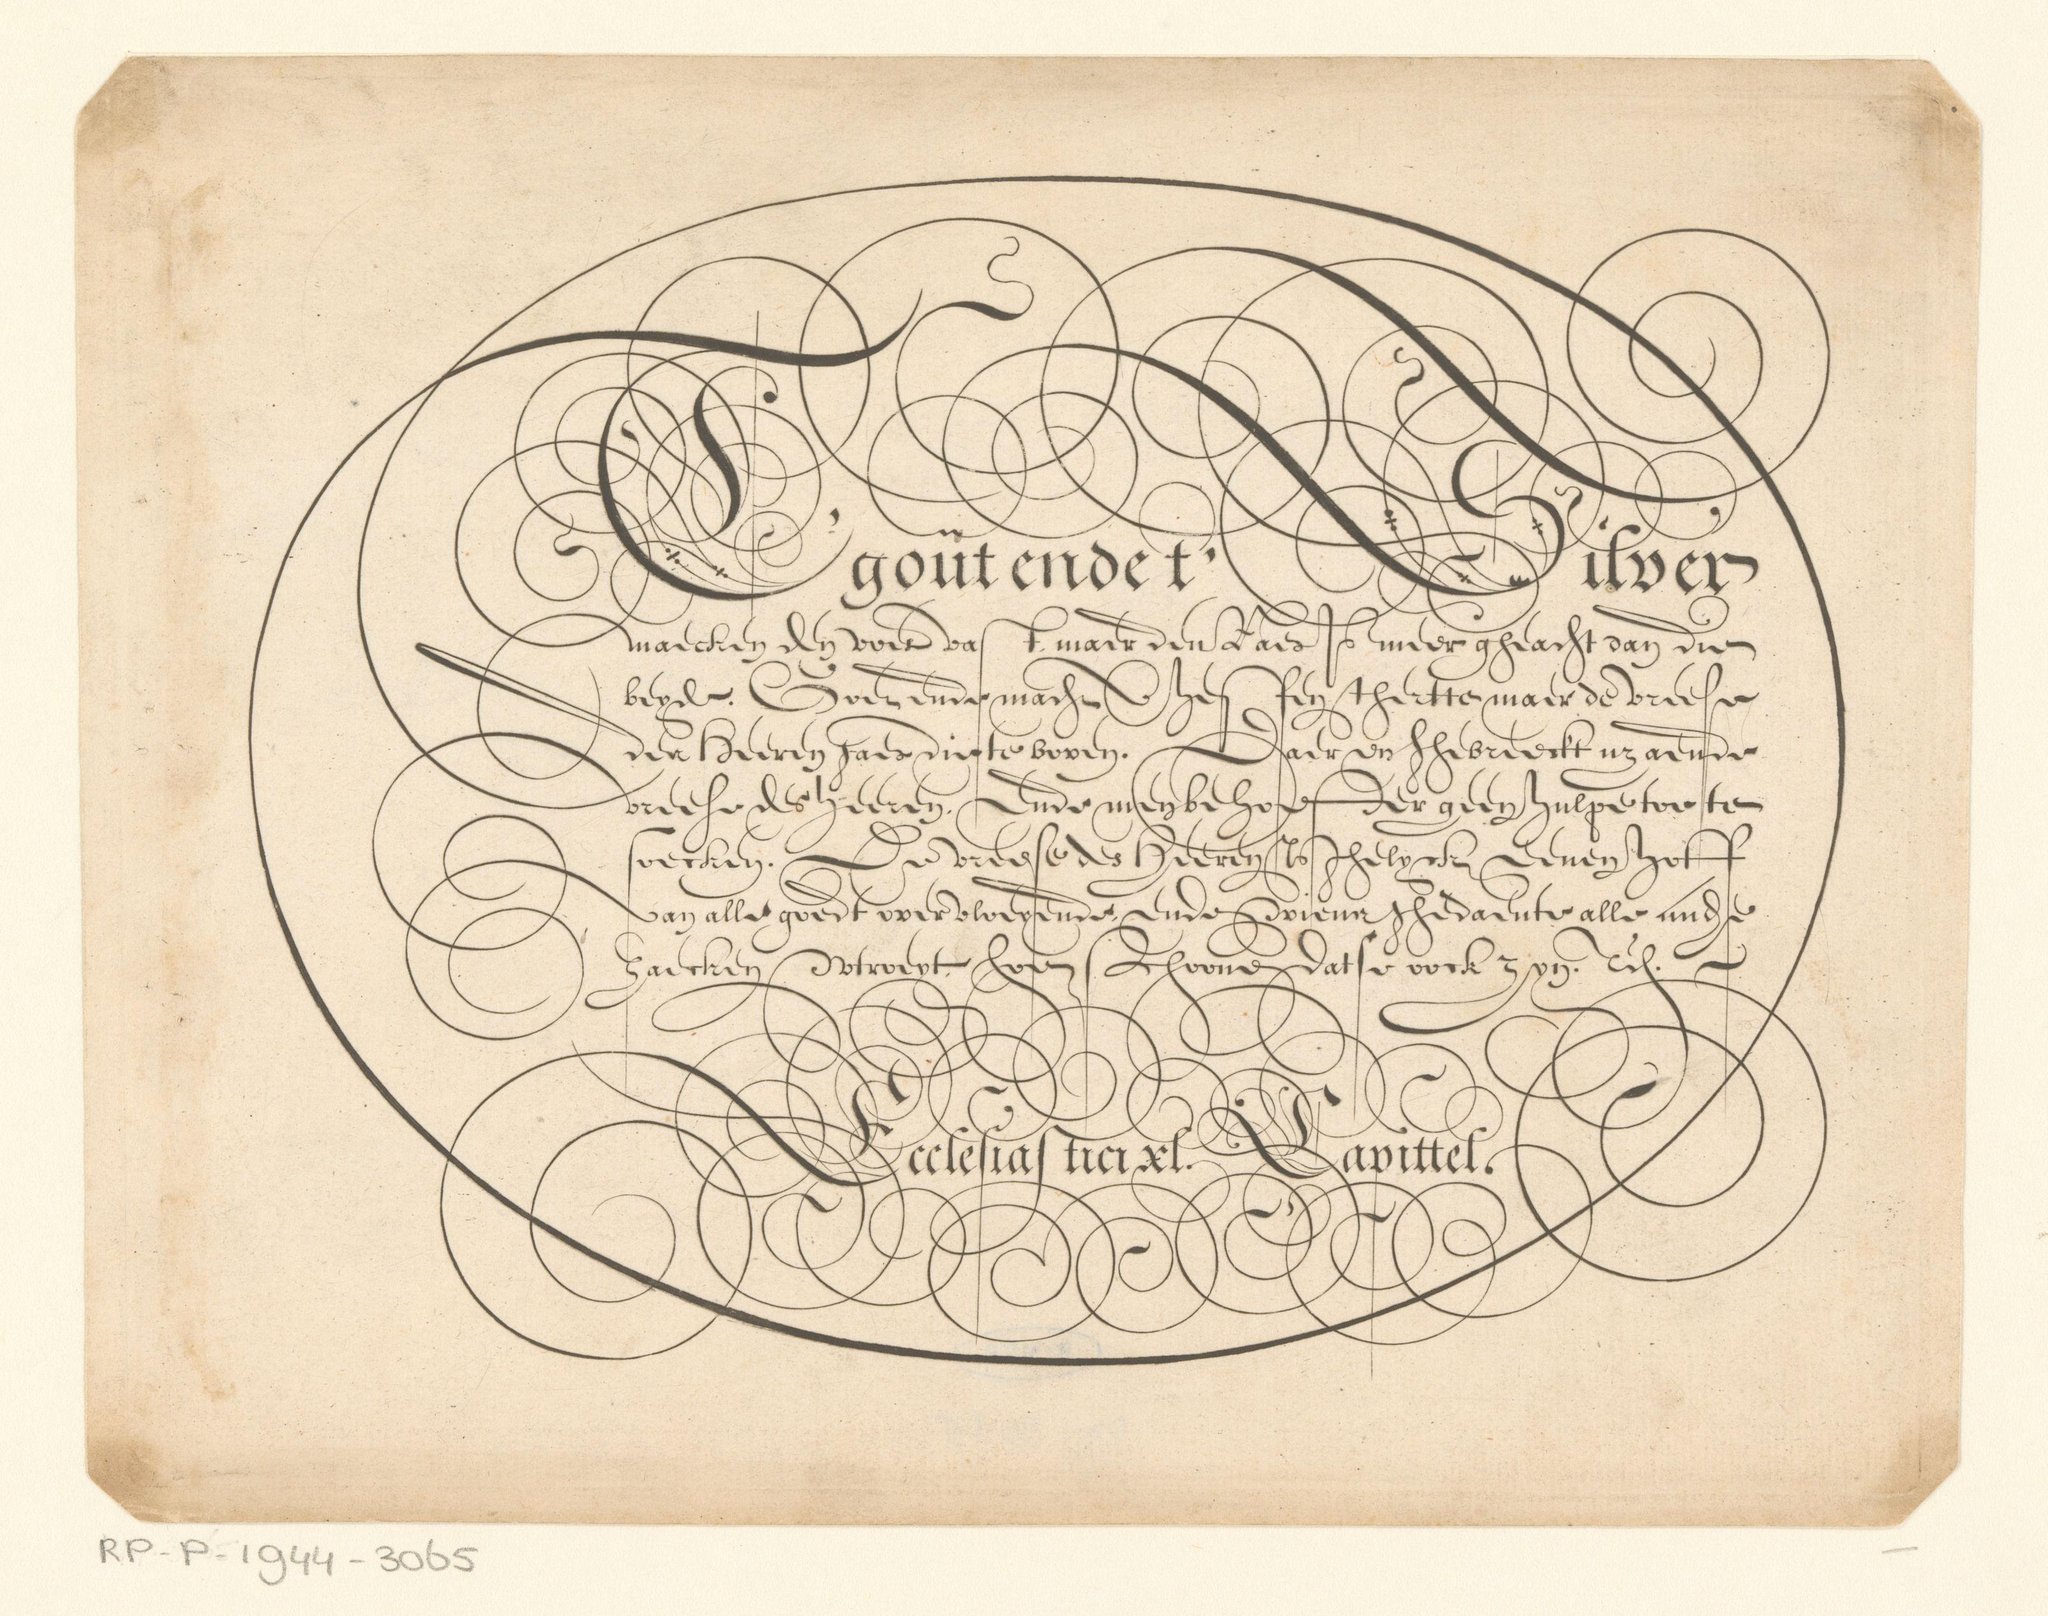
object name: print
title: Schrijfvoorbeeld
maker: Anonymous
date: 1575-1625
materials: paper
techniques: engraving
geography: netherlands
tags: calligraphy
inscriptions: collector's mark: Lugt 2228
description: Prent is onderdeel van een serie van zes. Zie RP-P-1944-3063, -3064, -3065, -3067, -3071 en -3073.